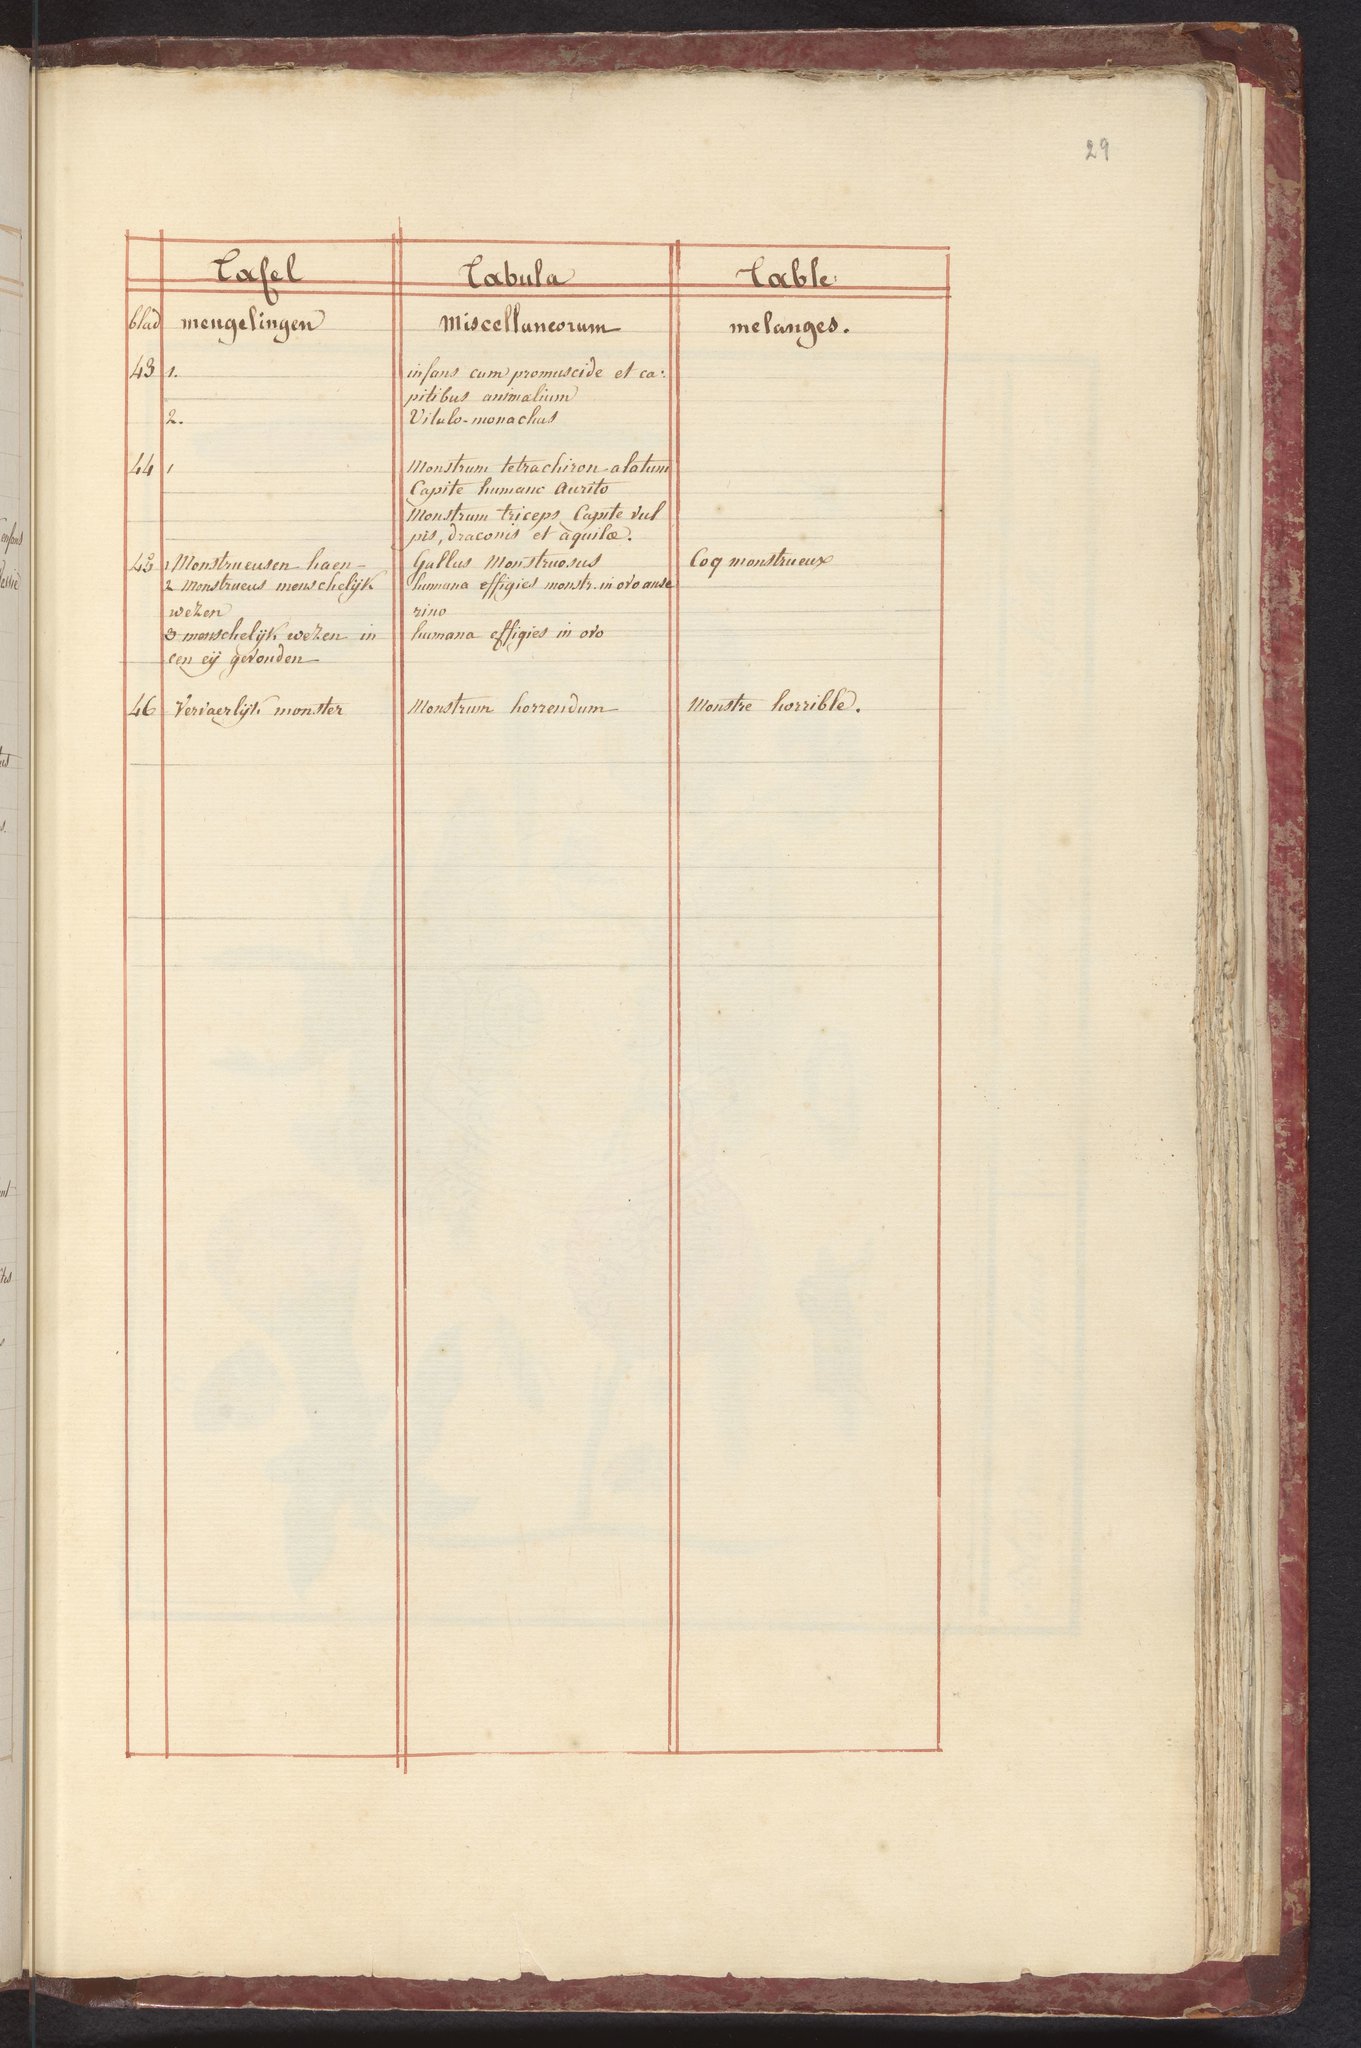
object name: manuscript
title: Tafel MIngelingen / Tabula miscellaneorum / Table des melanges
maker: joseph van huerne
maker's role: kunstliefhebber, mecenas, verzamelaar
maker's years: 1752-1844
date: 1809-1814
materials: ink, paper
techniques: handwriting, pen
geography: bruges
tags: handwriting, written text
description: Schema met een lijst in drie kolommen van de overige natuurhistorische voorstellingen (vervolg), nummers 43-46. Onderdeel van het zevende album met tekeningen van reptielen, amfibieën en natuurhistorische ensembles. Het zevende van twaalf albums met aquarellen van dieren, vogels en planten bekend rond 1600, gemaakt in opdracht van keizer Rudolf II. Met toelichting in Nederlands, Latijn en Frans.